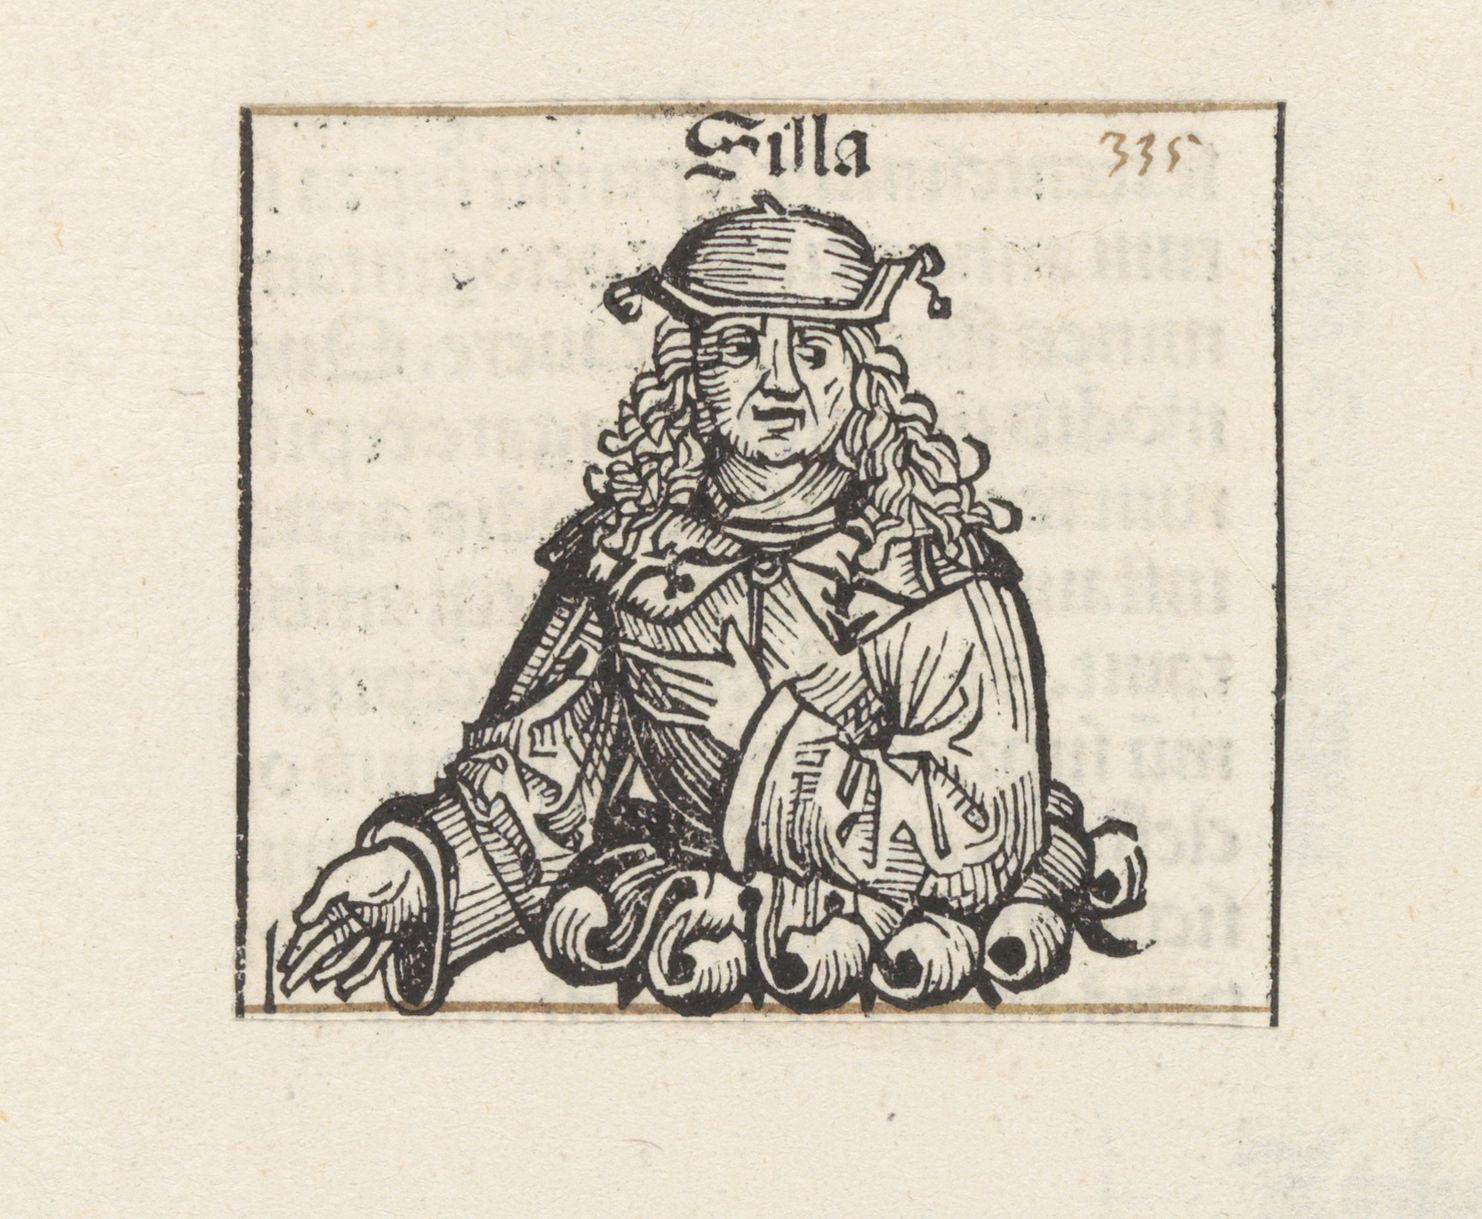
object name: print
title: Silla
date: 1493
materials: paper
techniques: letterpress printing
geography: nuremberg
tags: male persons from classical history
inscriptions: inscription: ‘335’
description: Een bloemkelk met een man, zijn hoofd naar rechts gedraaid. De voorstelling is onderdeel van de lijst van Romeinse consuls in de Liber Chronicarum. De tekst identificeert de man als Lucius Cornelius Sulla. De prent maakt deel uit van een album.